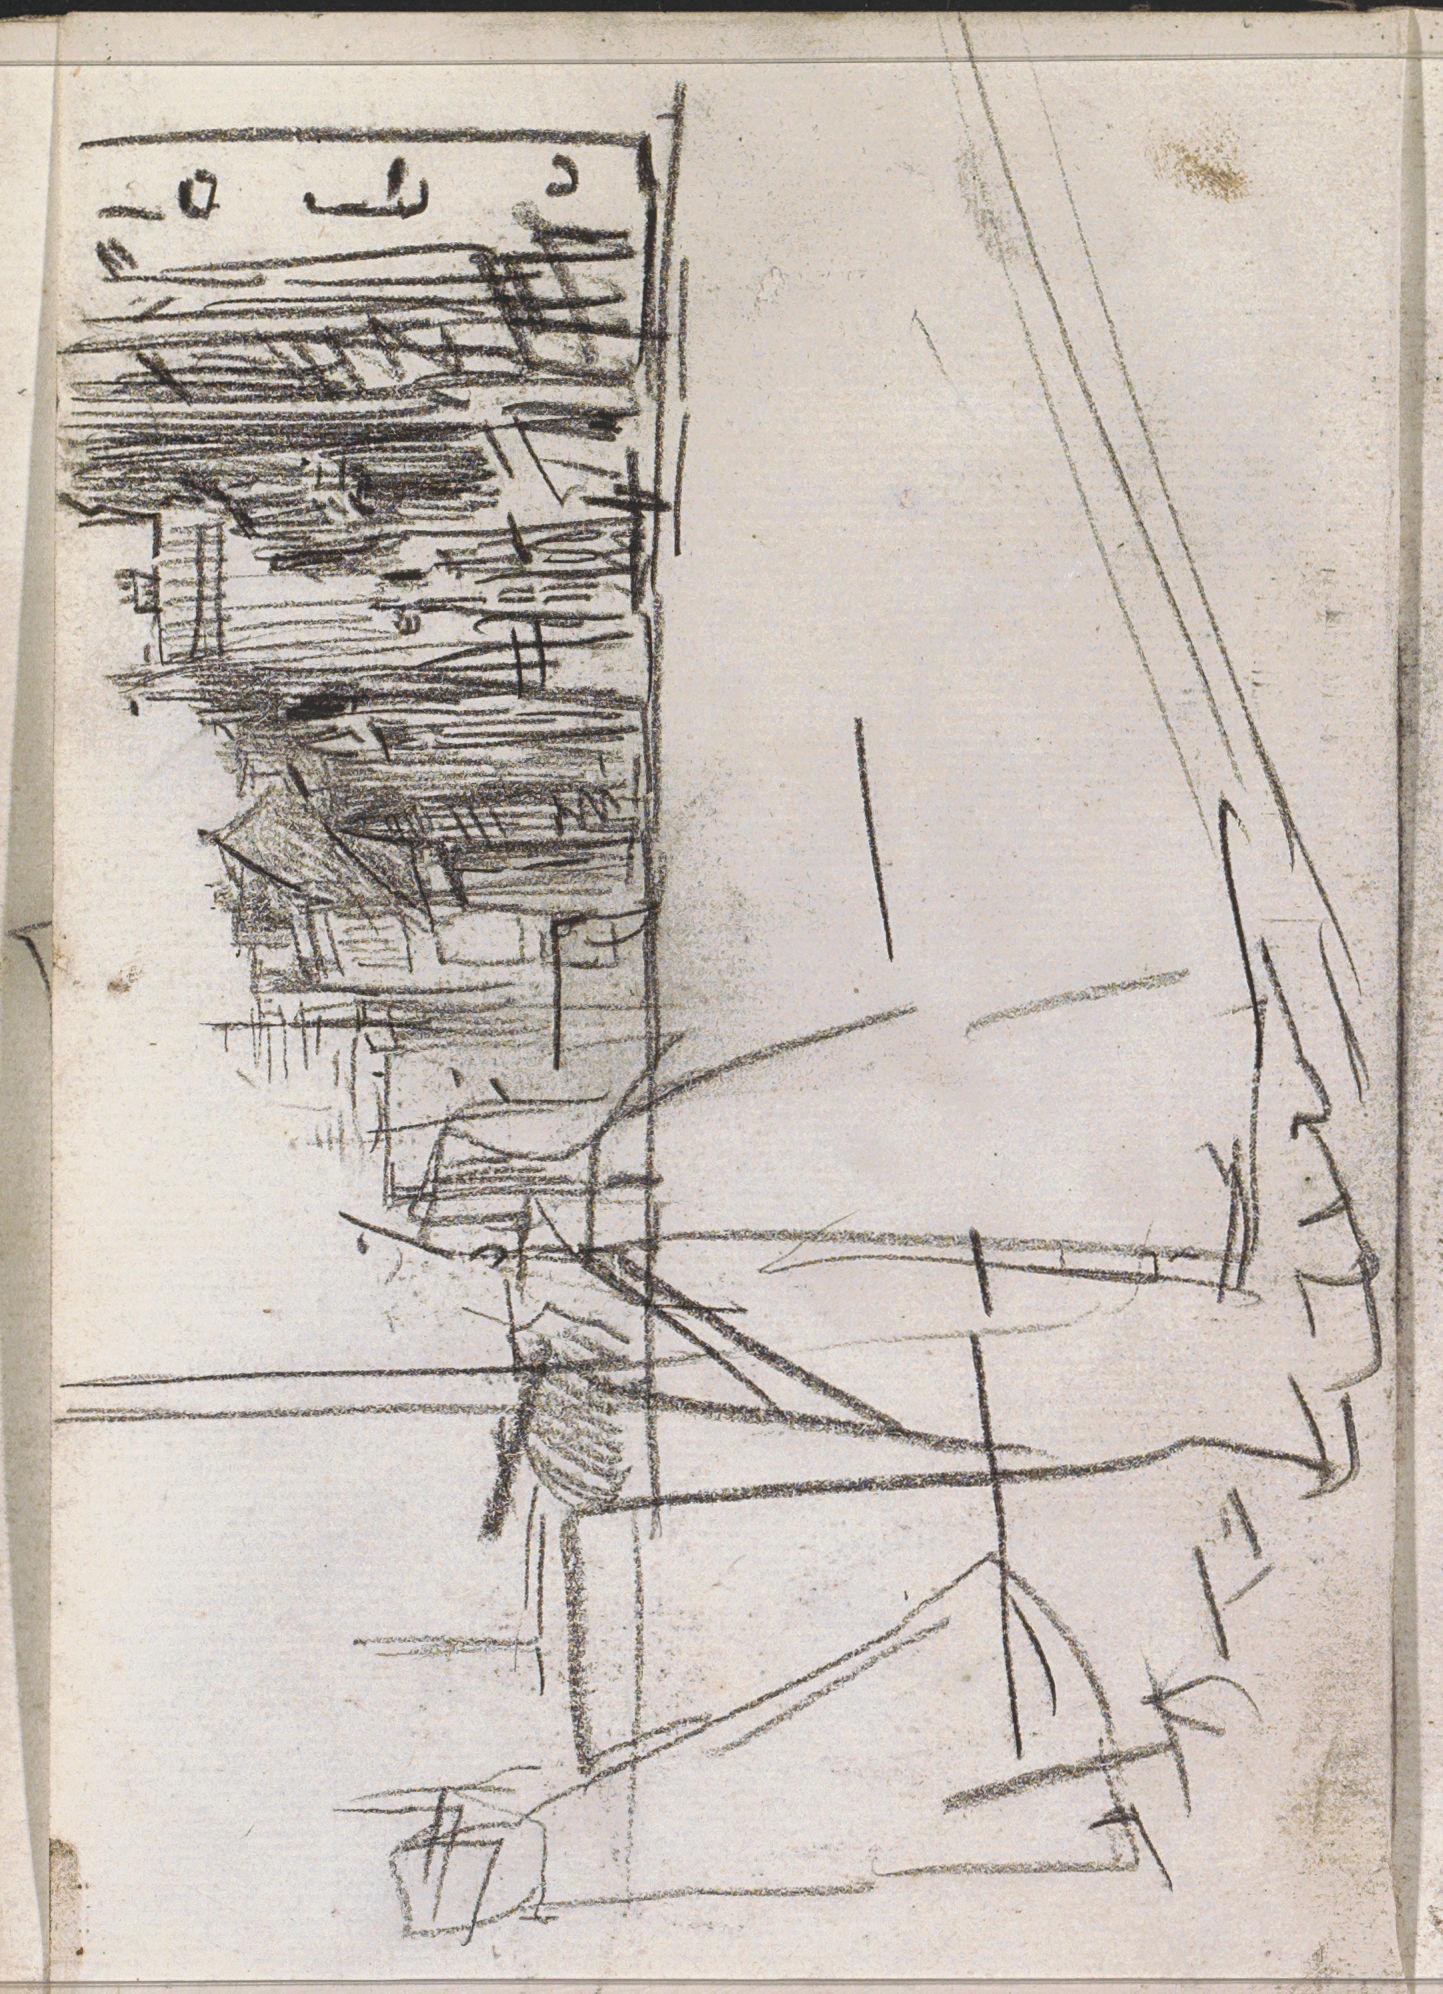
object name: sketchbook leaf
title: Figuren op straat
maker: isaac israels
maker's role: draughtsman, painter, print maker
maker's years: 1865-1934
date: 1875-1934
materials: chalk, paper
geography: the hague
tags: street (+ city(-scape) with figures, staffage)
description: Pagina 9 uit schetsboek XLIV met 43 pagina's.